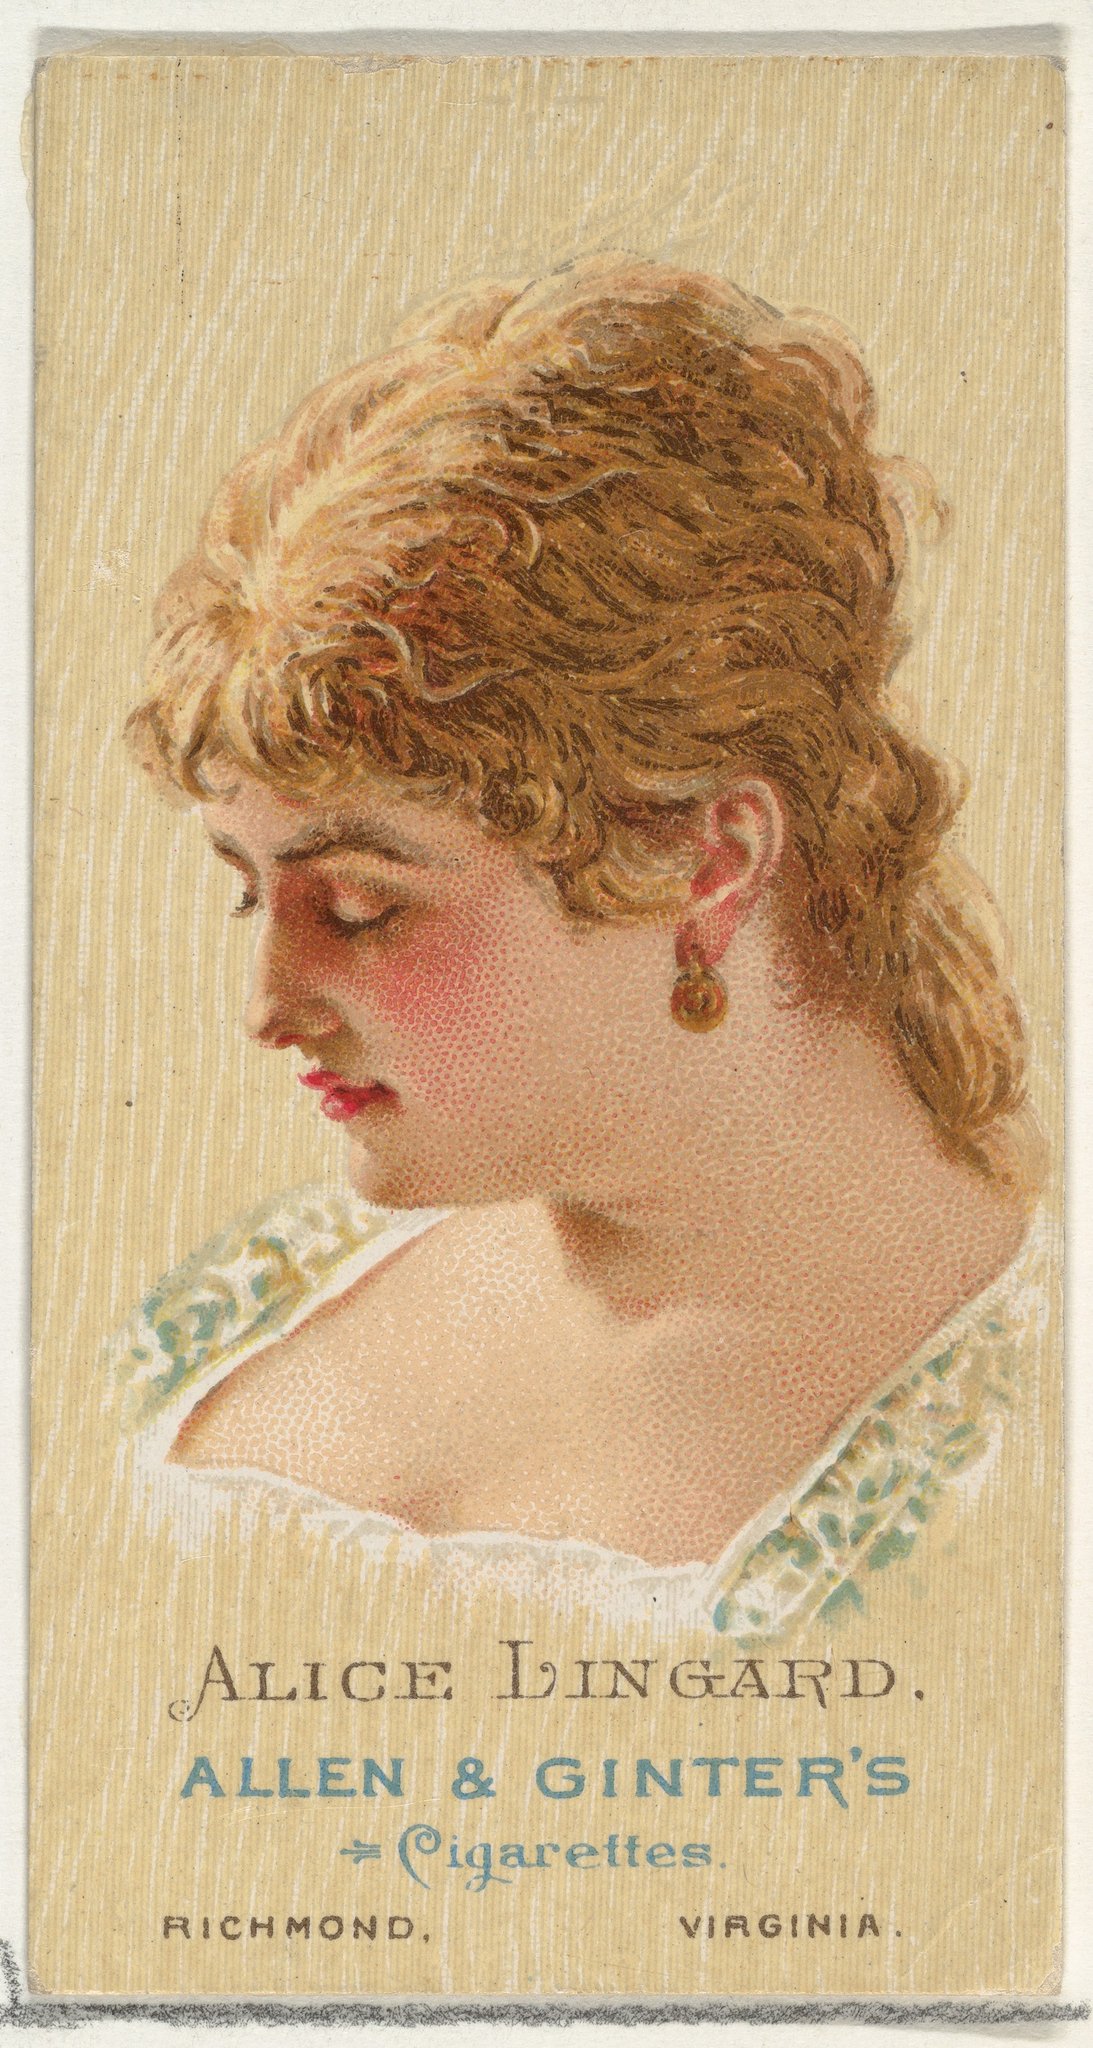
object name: print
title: Alice Lingard, from World's Beauties, Series 2 (N27) for Allen & Ginter Cigarettes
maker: allen & ginter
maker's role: publisher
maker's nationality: american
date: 1888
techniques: color lithograph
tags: women